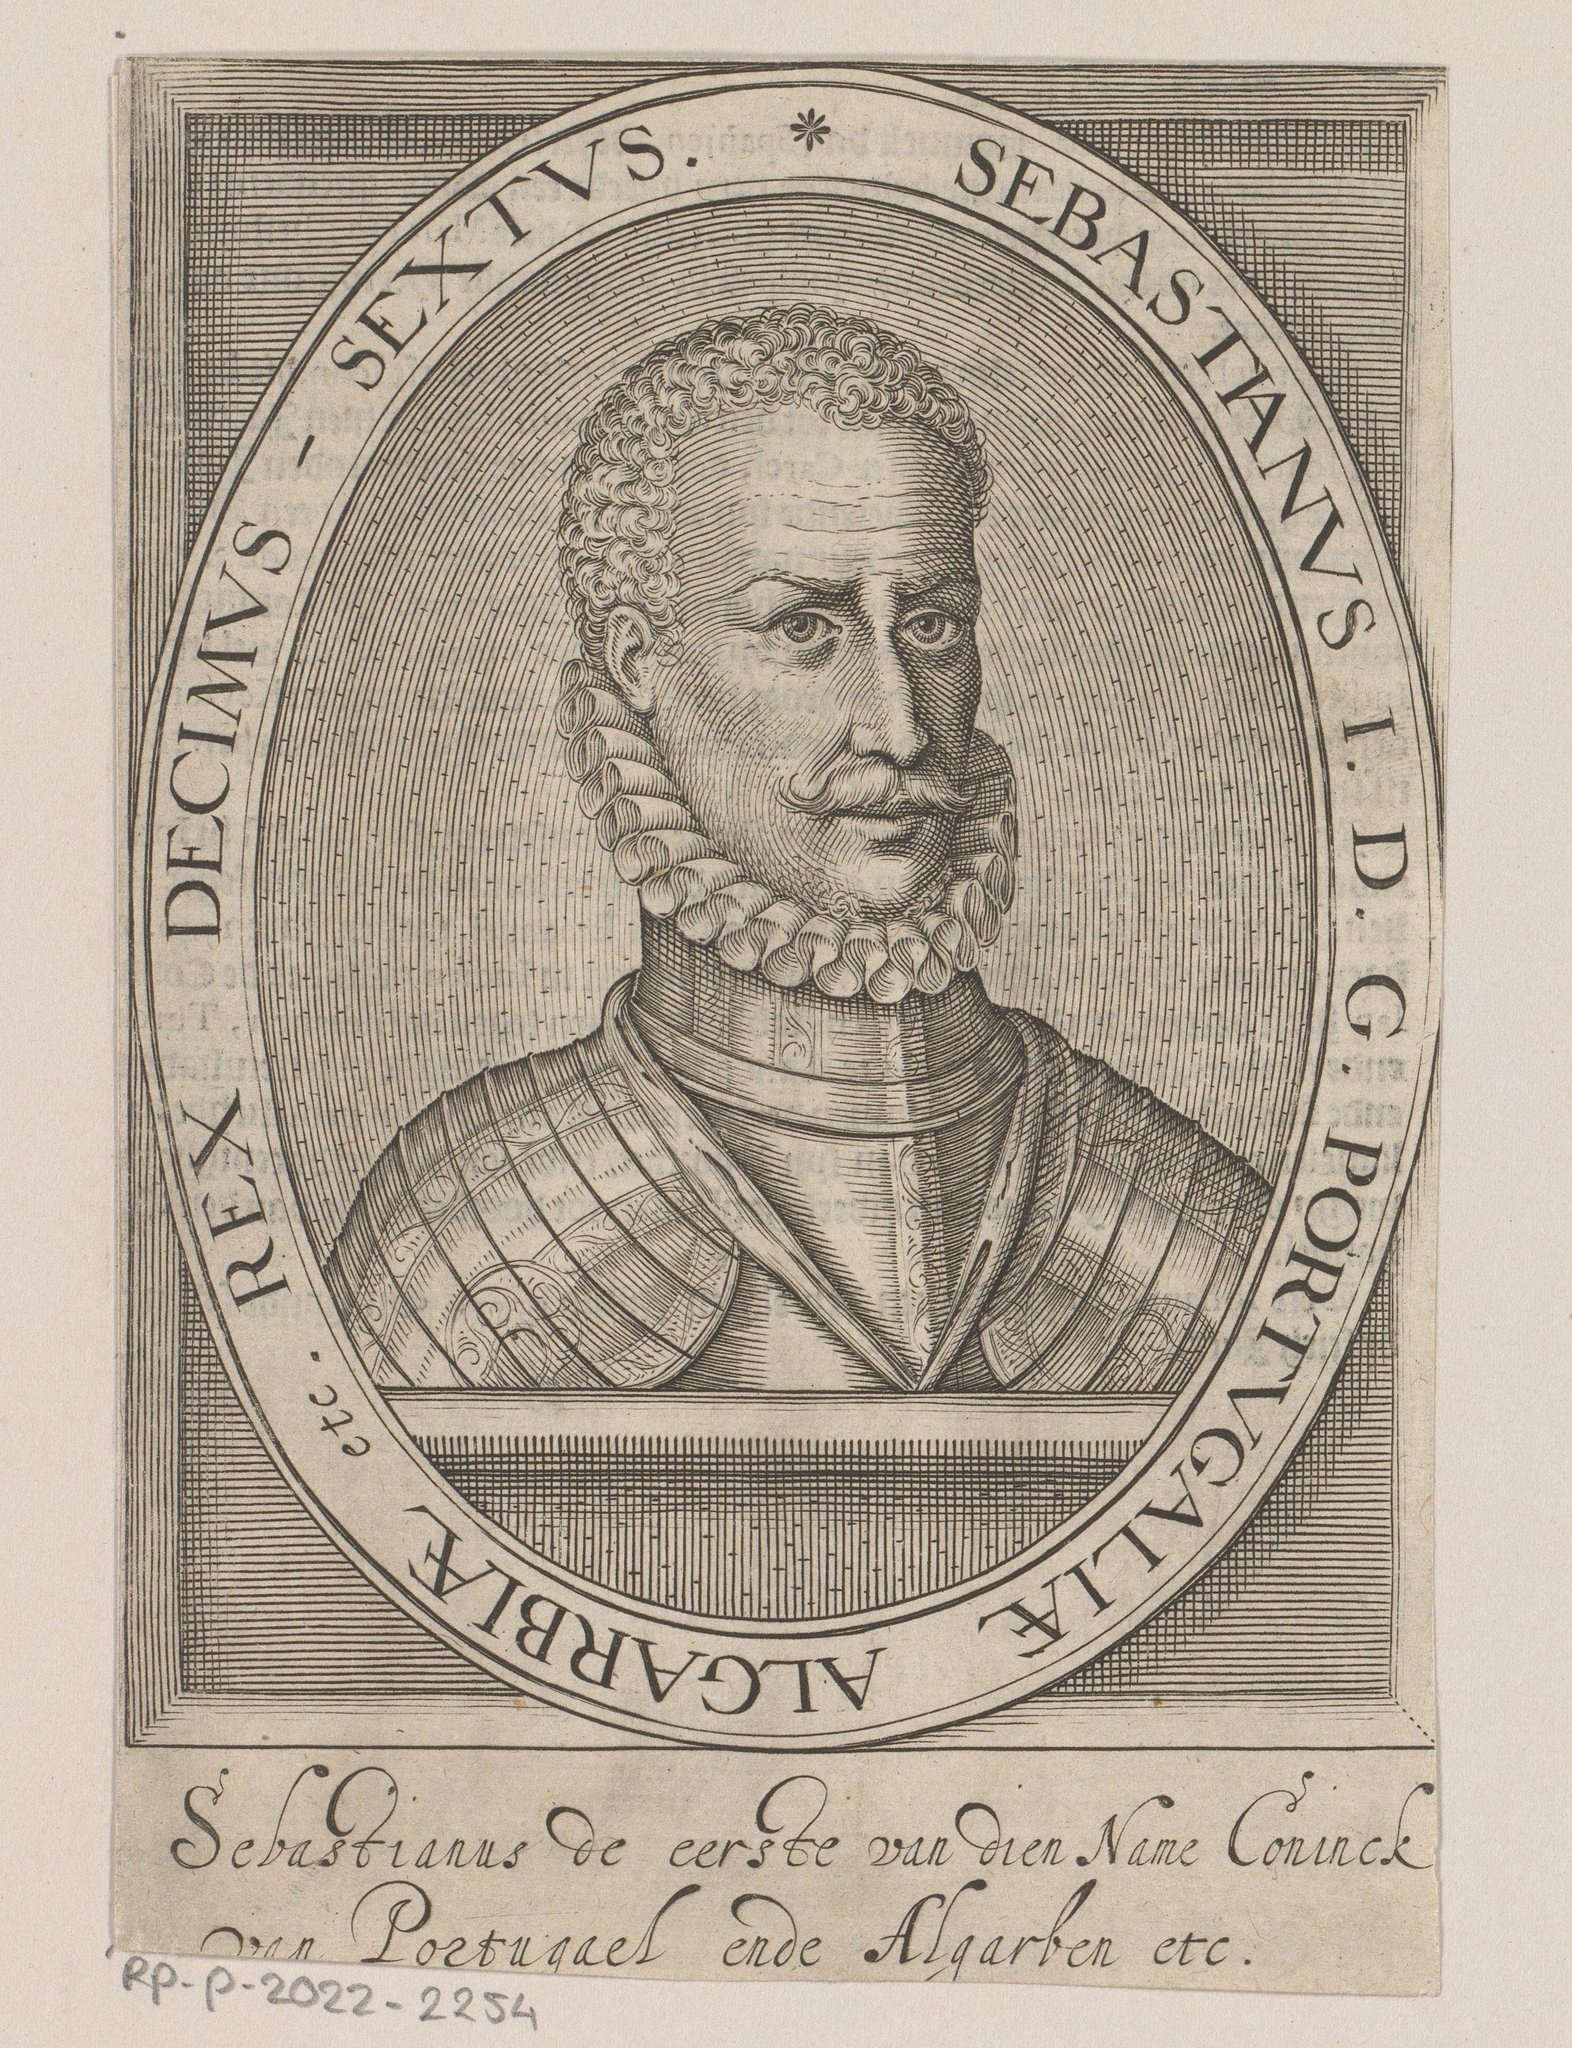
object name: book illustration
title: Portret van Sebastiaan I van Portugal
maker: Anonymous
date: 1600-1699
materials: paper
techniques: engraving, letterpress printing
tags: historical persons, king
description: Met tweeregelig onderschrift in het Nederlands en tekst in het Latijn rondom het portret.